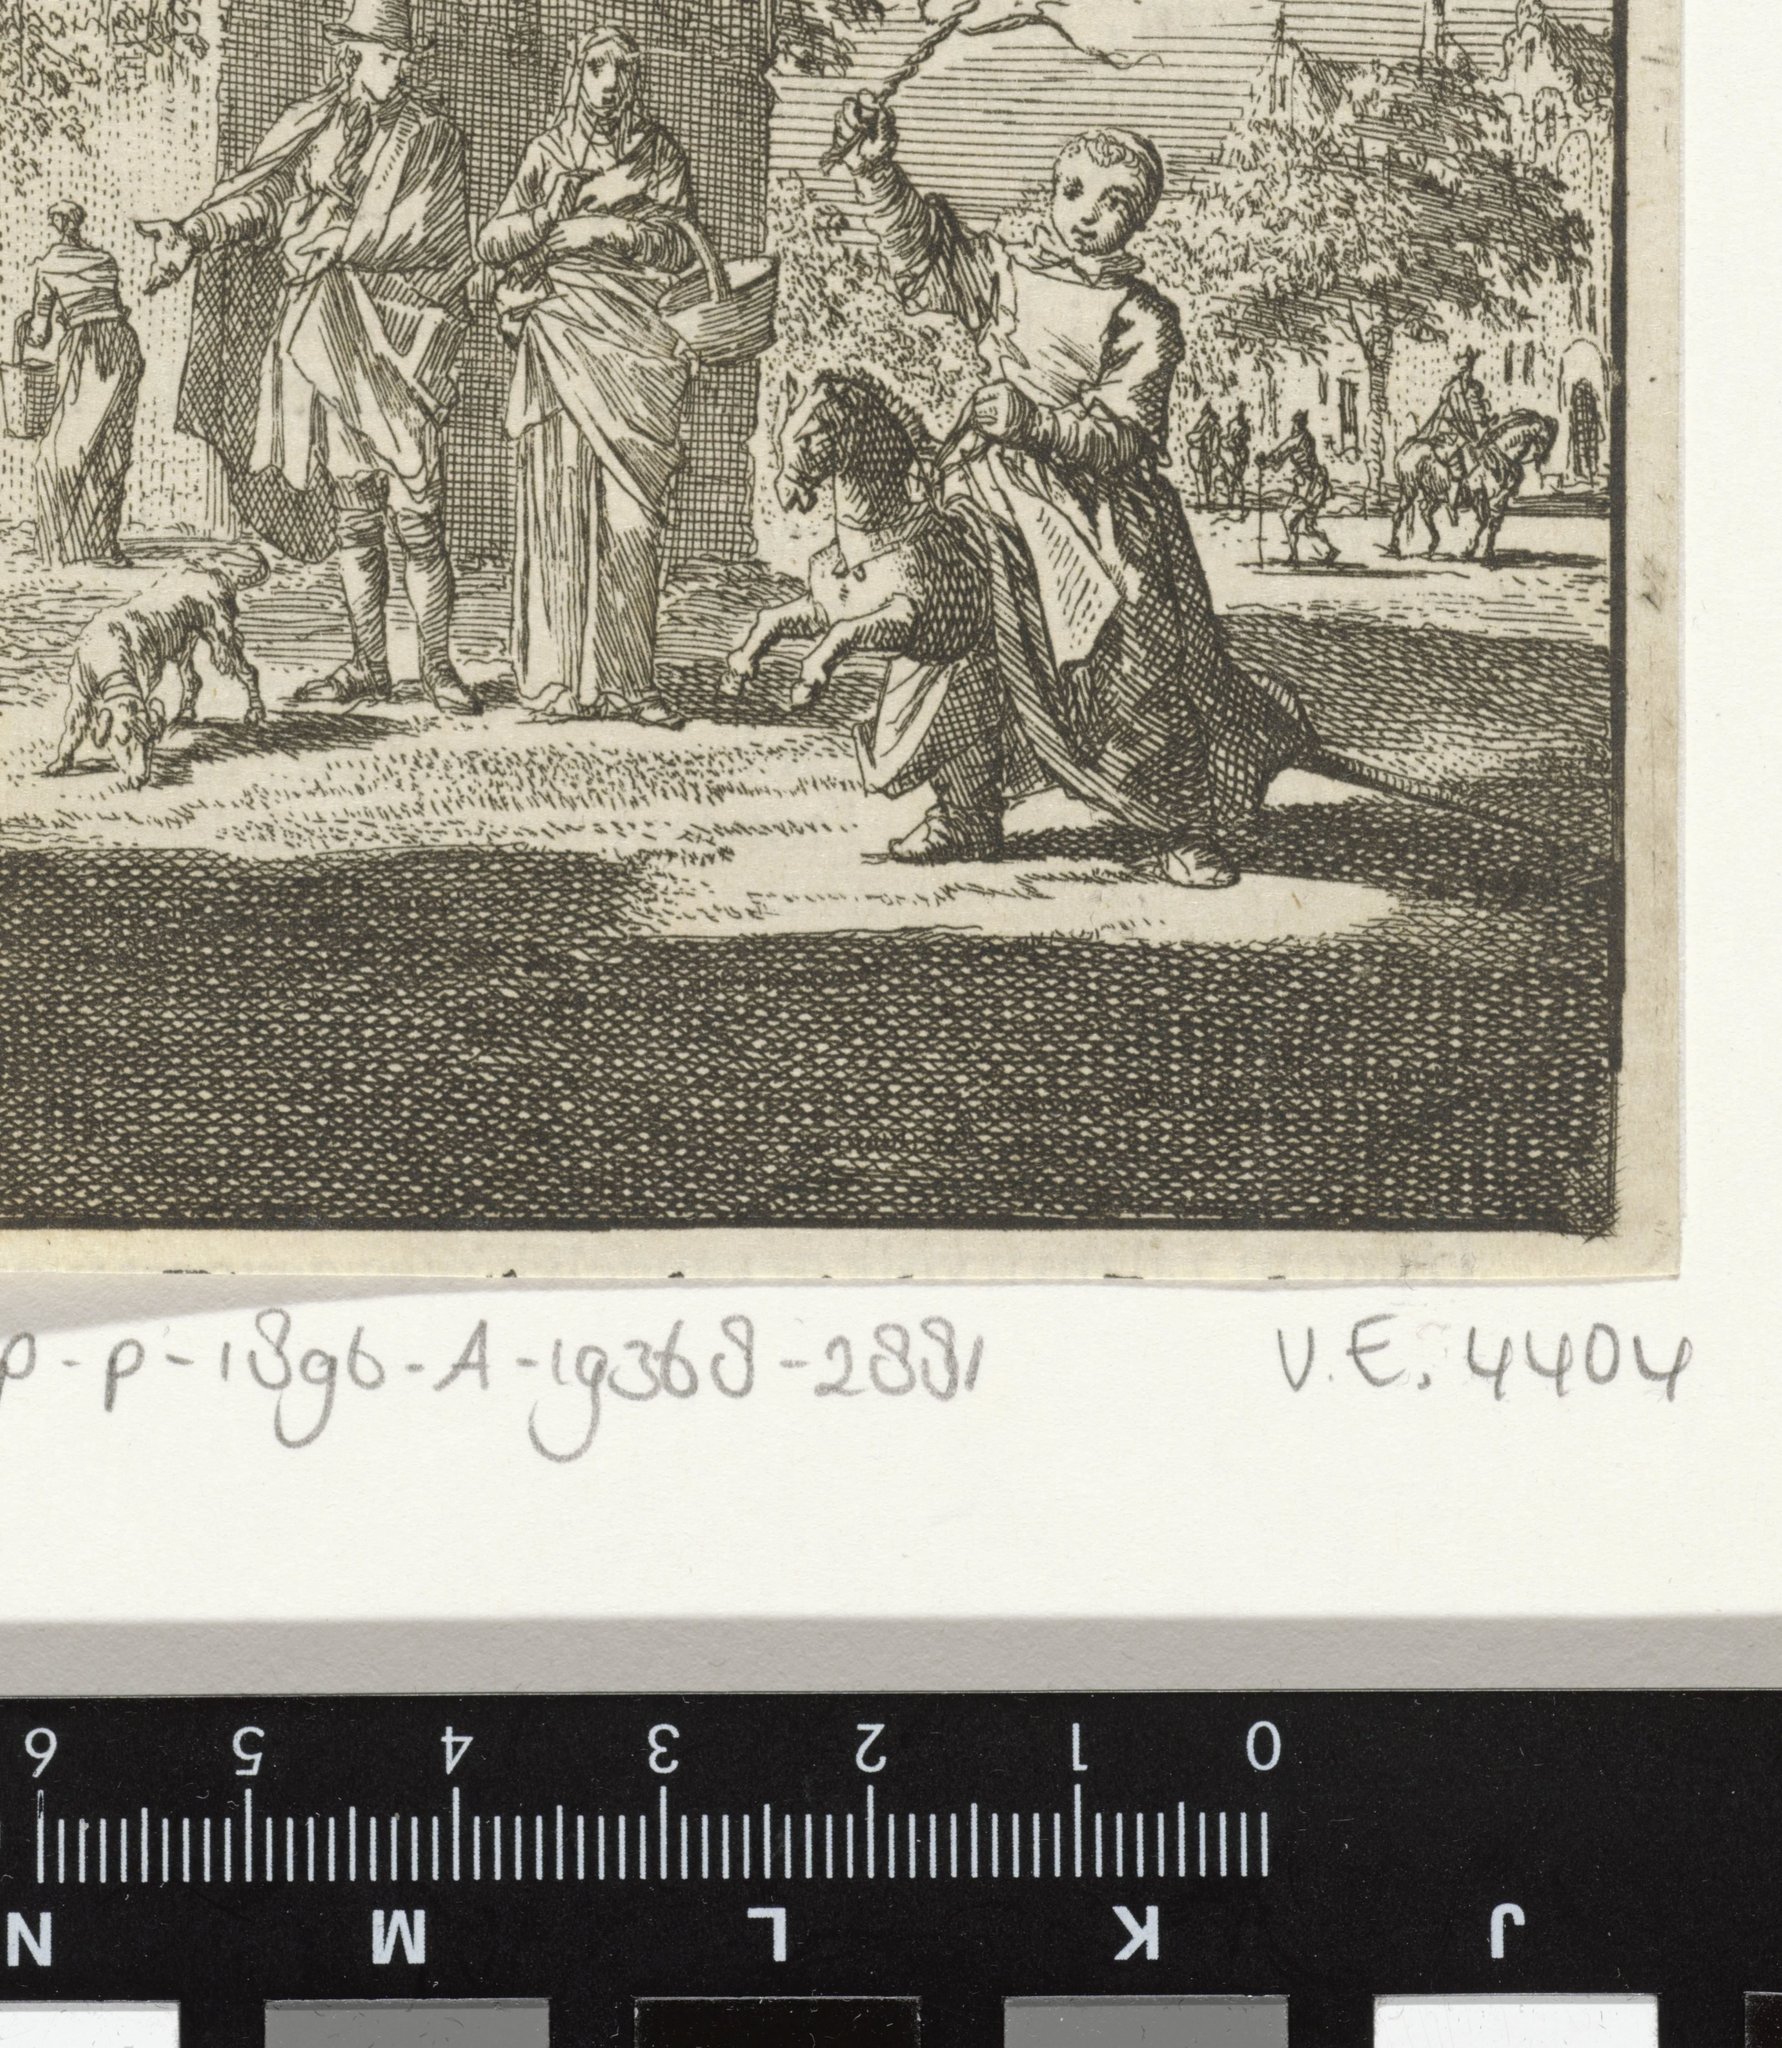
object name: book illustration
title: Spelend kind op een stokpaard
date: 1712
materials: paper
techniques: etching, letterpress printing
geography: amsterdam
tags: hobby-horse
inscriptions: collector's mark: Lugt 2228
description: Illustratie uit: Luyken, Jan. Des menschen begin, midden en einde. Amsterdam: Wed. Pieter Arentsz II en Cornelis van der Sys, 1712, p. 33.